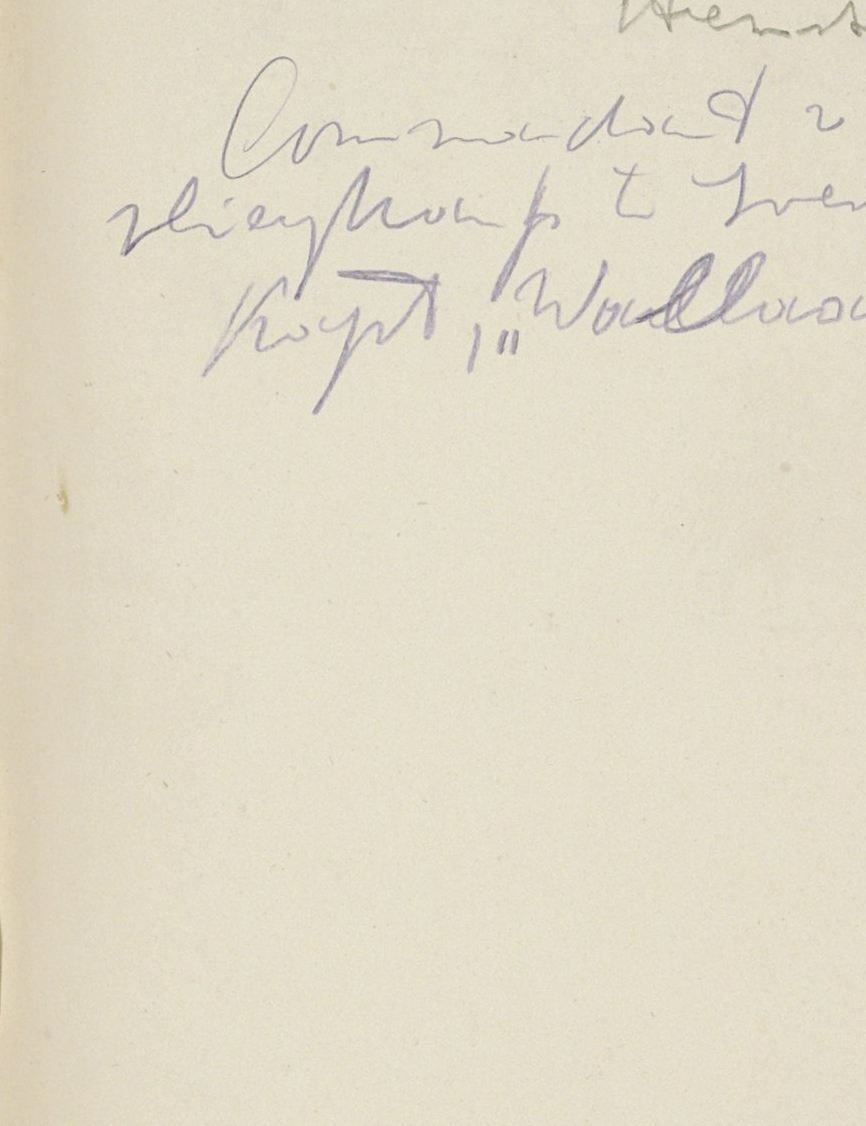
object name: sketchbook leaf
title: Notitie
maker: reijer stolk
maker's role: draughtsman, print maker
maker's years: 1896-1945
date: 1906-1945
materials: paper, pencil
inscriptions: annotation: ‘[...]’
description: Blad 69 recto uit een schetsboek met 69 bladen.